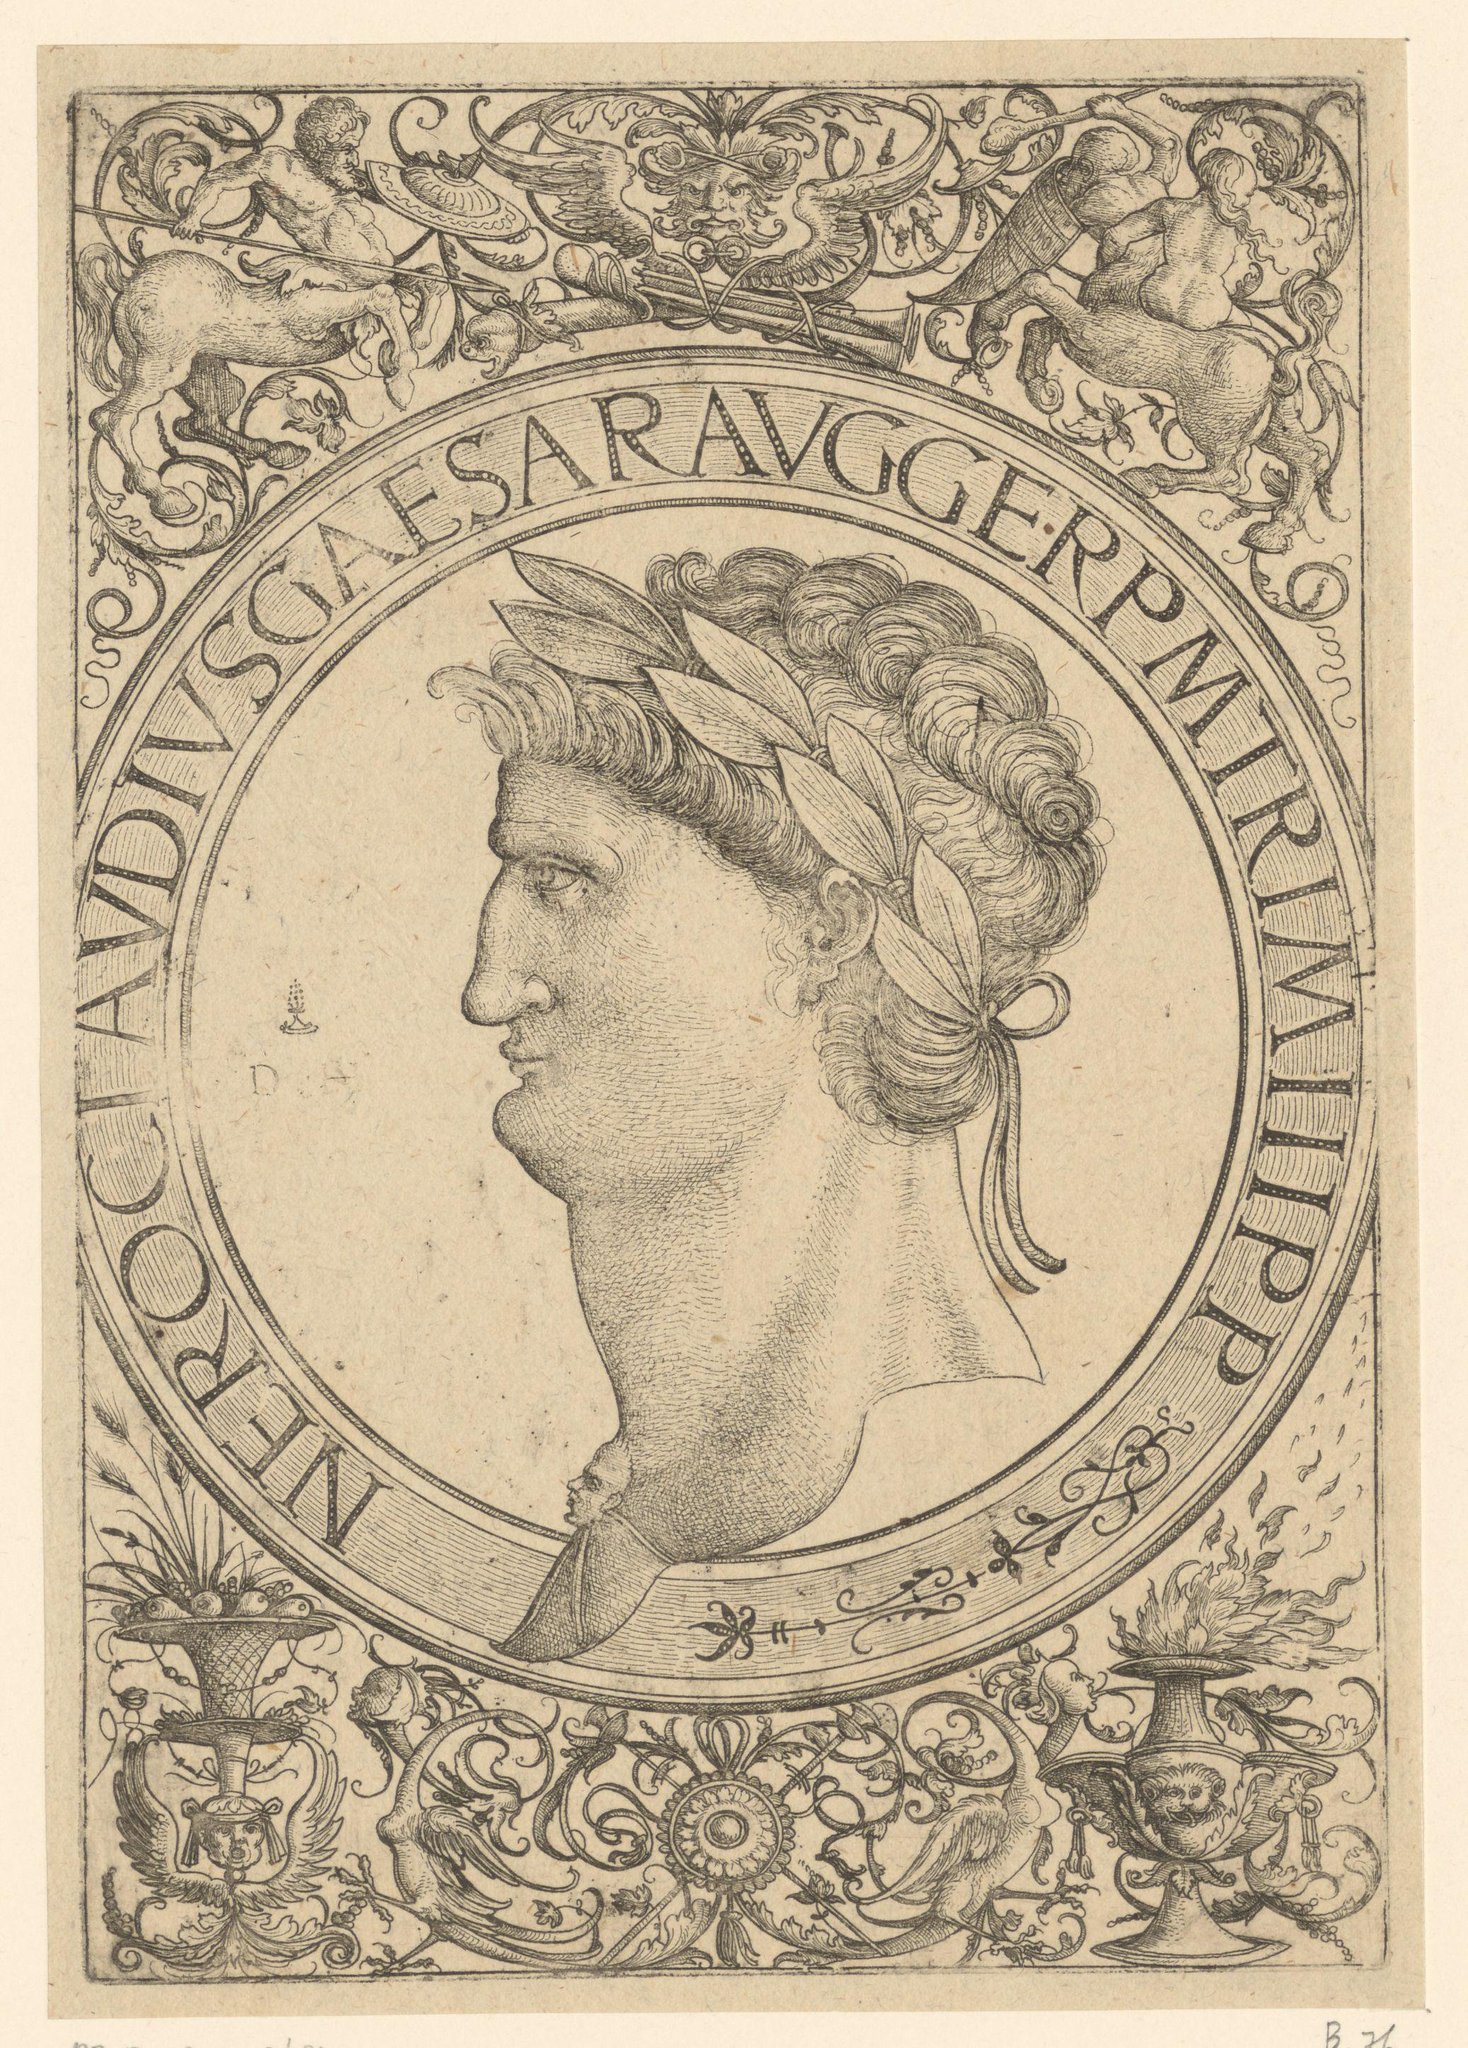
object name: print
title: Portret van Nero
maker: daniel hopfer (i)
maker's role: print maker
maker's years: 1470-1536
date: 1505-1536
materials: paper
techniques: etching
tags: ornament ~ grotesque, ornament ~ medallion, historical persons, pope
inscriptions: collector's mark: Lugt 2228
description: Borstbeeld van de Romeinse keizer Nero en profil naar links in een medaillon. Tekst in het Latijn in de omlijsting. Mythologische en groteske figuren sieren het kader om het medaillon heen.